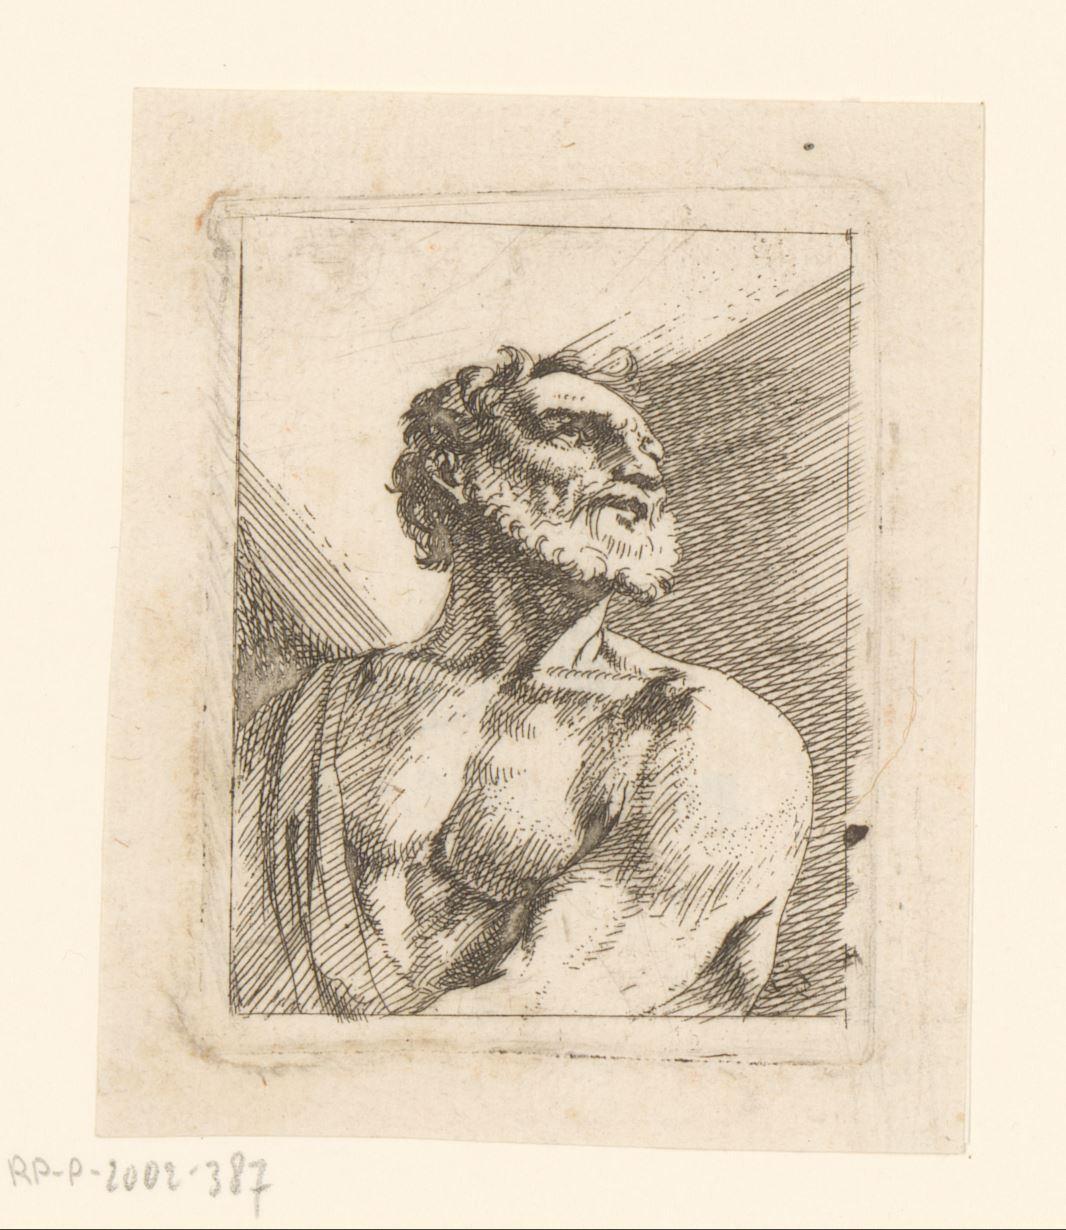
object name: print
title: Buste van een man met ontblote schouder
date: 1626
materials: paper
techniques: etching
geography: augsburg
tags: head (human)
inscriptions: collector's mark: Lugt 2228, collector's mark: Lugt 2760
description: Gebaseerd op de verschillende staten van de titelprent van deze serie (voor tweede staat zie RP-P-2002-384), is deze serie in ieder geval vier keer uitgeven. Voor het eerst in 1626 (jaartal vermeld op titelprent) en vervolgens in ieder geval drie keer door de Augsburgse uitgever Jeremias Wolf, die van 1686 tot 1724 actief was. Het is onduidelijk tot welke uitgave dit exemplaar behoort.